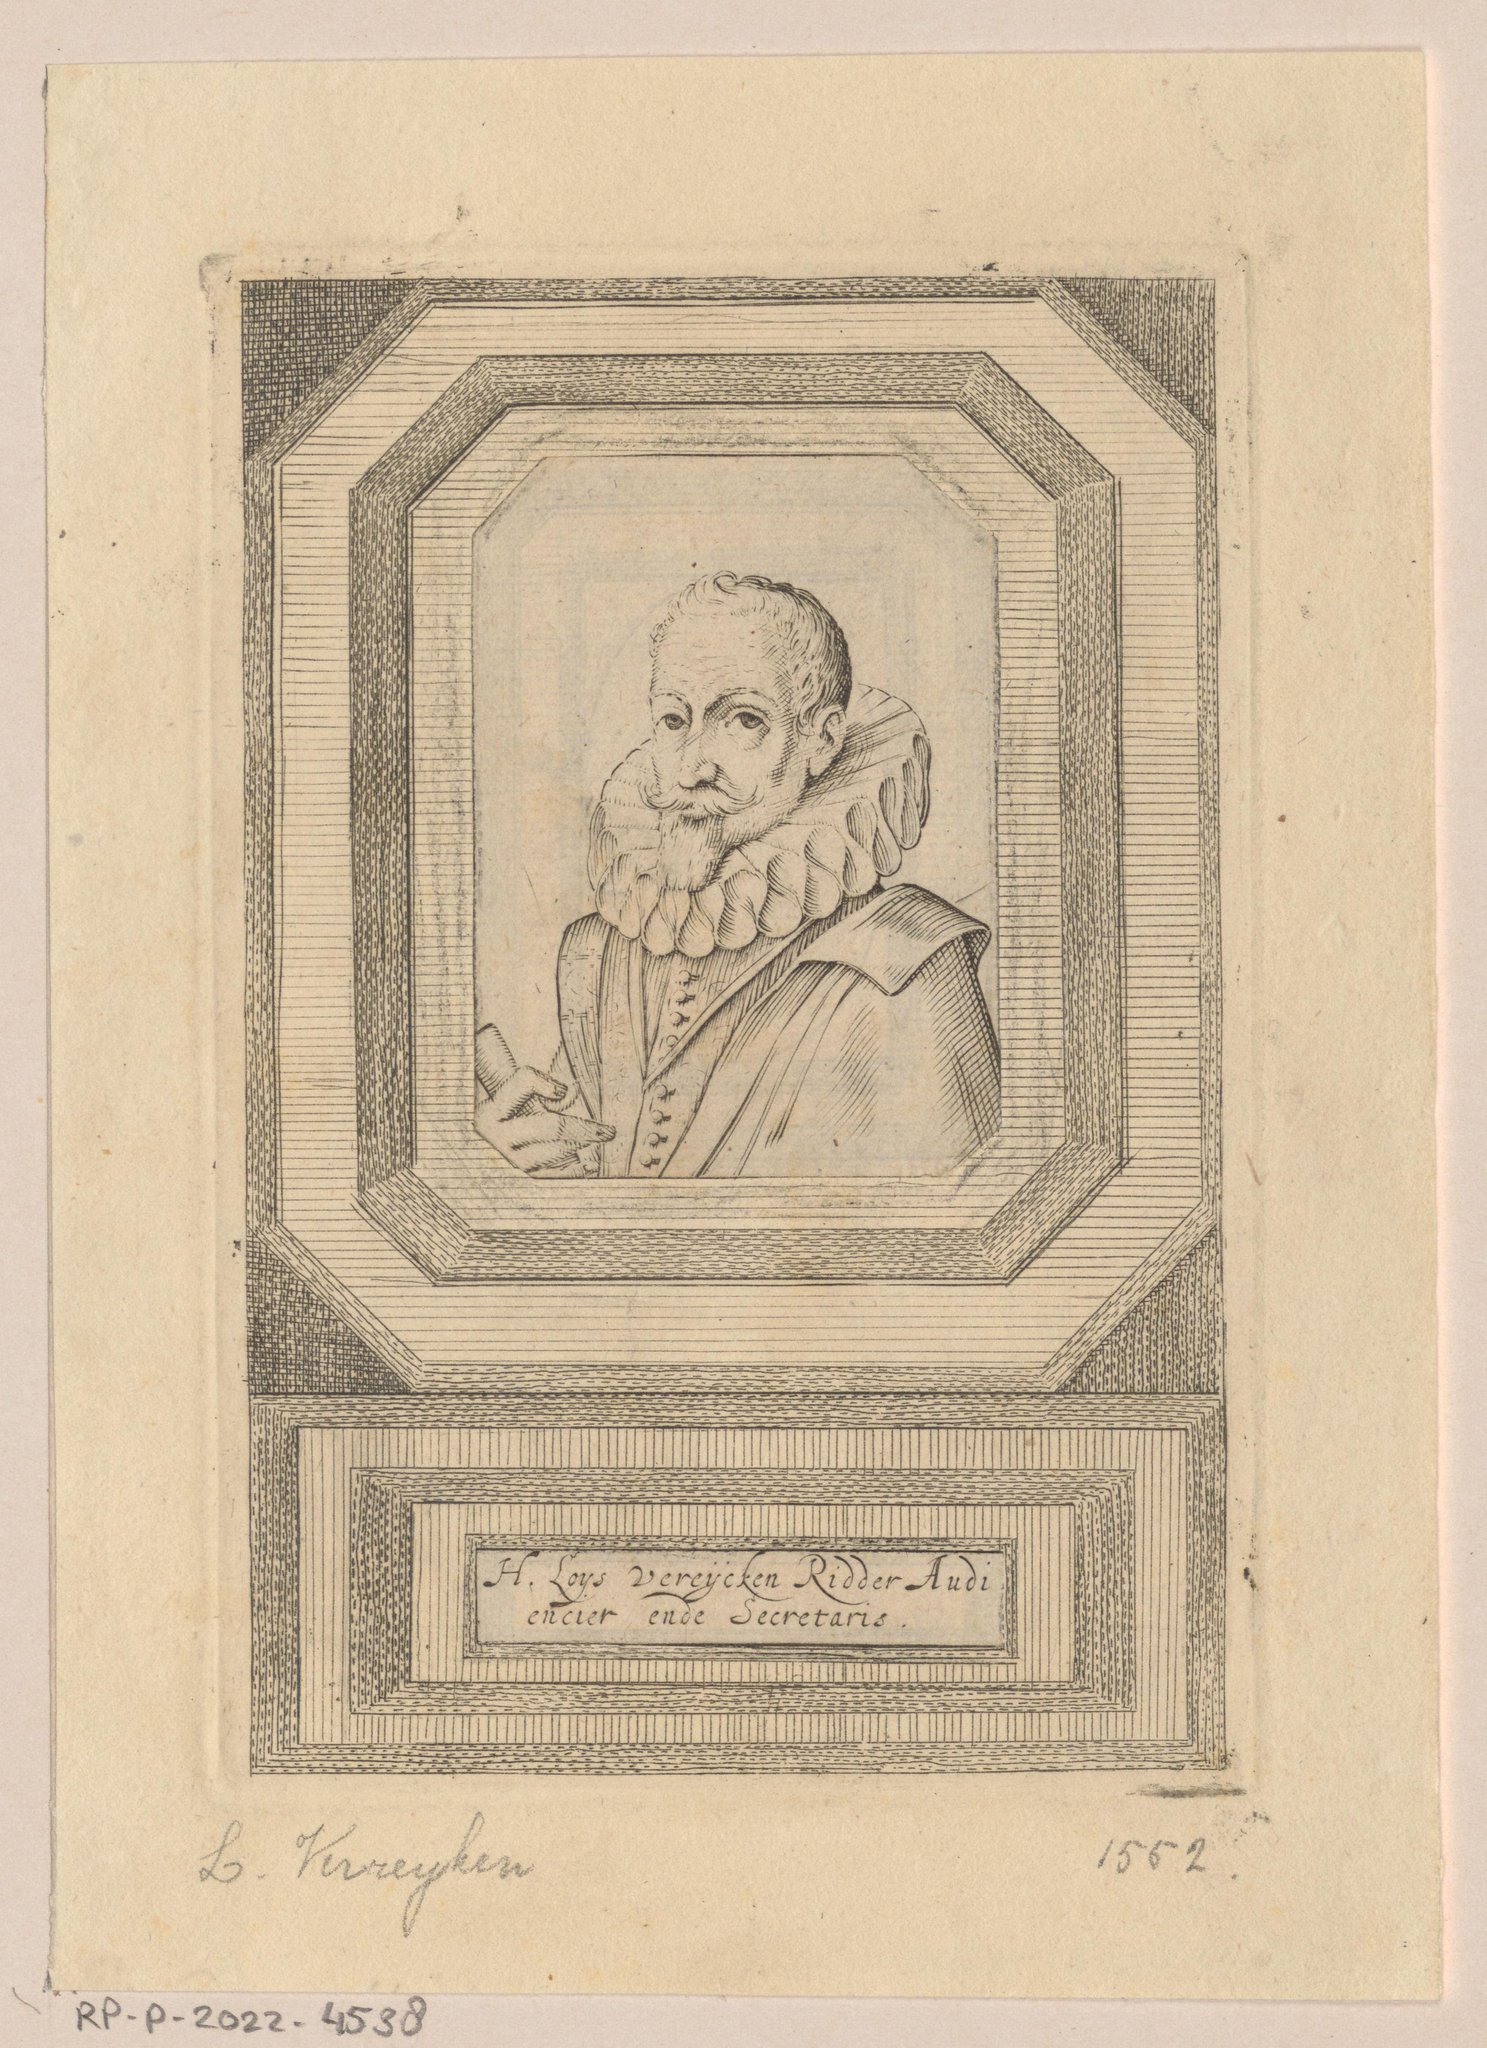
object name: print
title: Portret van Lodewijk Verreyken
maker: Anonymous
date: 1627-1725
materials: paper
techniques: engraving, etching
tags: official; civil servant; functionary (in general), historical persons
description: Prent waarschijnlijk eerst gebruikt in uitgaves van: Meteren, Emanuel van. Eigentlich und volkomene historische Beschreibung des Niderlendischen Kriegs. Amsterdam: Johannes Janssonius, 1614 en 1627. Later verknipt en geplakt op een nieuwe omlijsting.